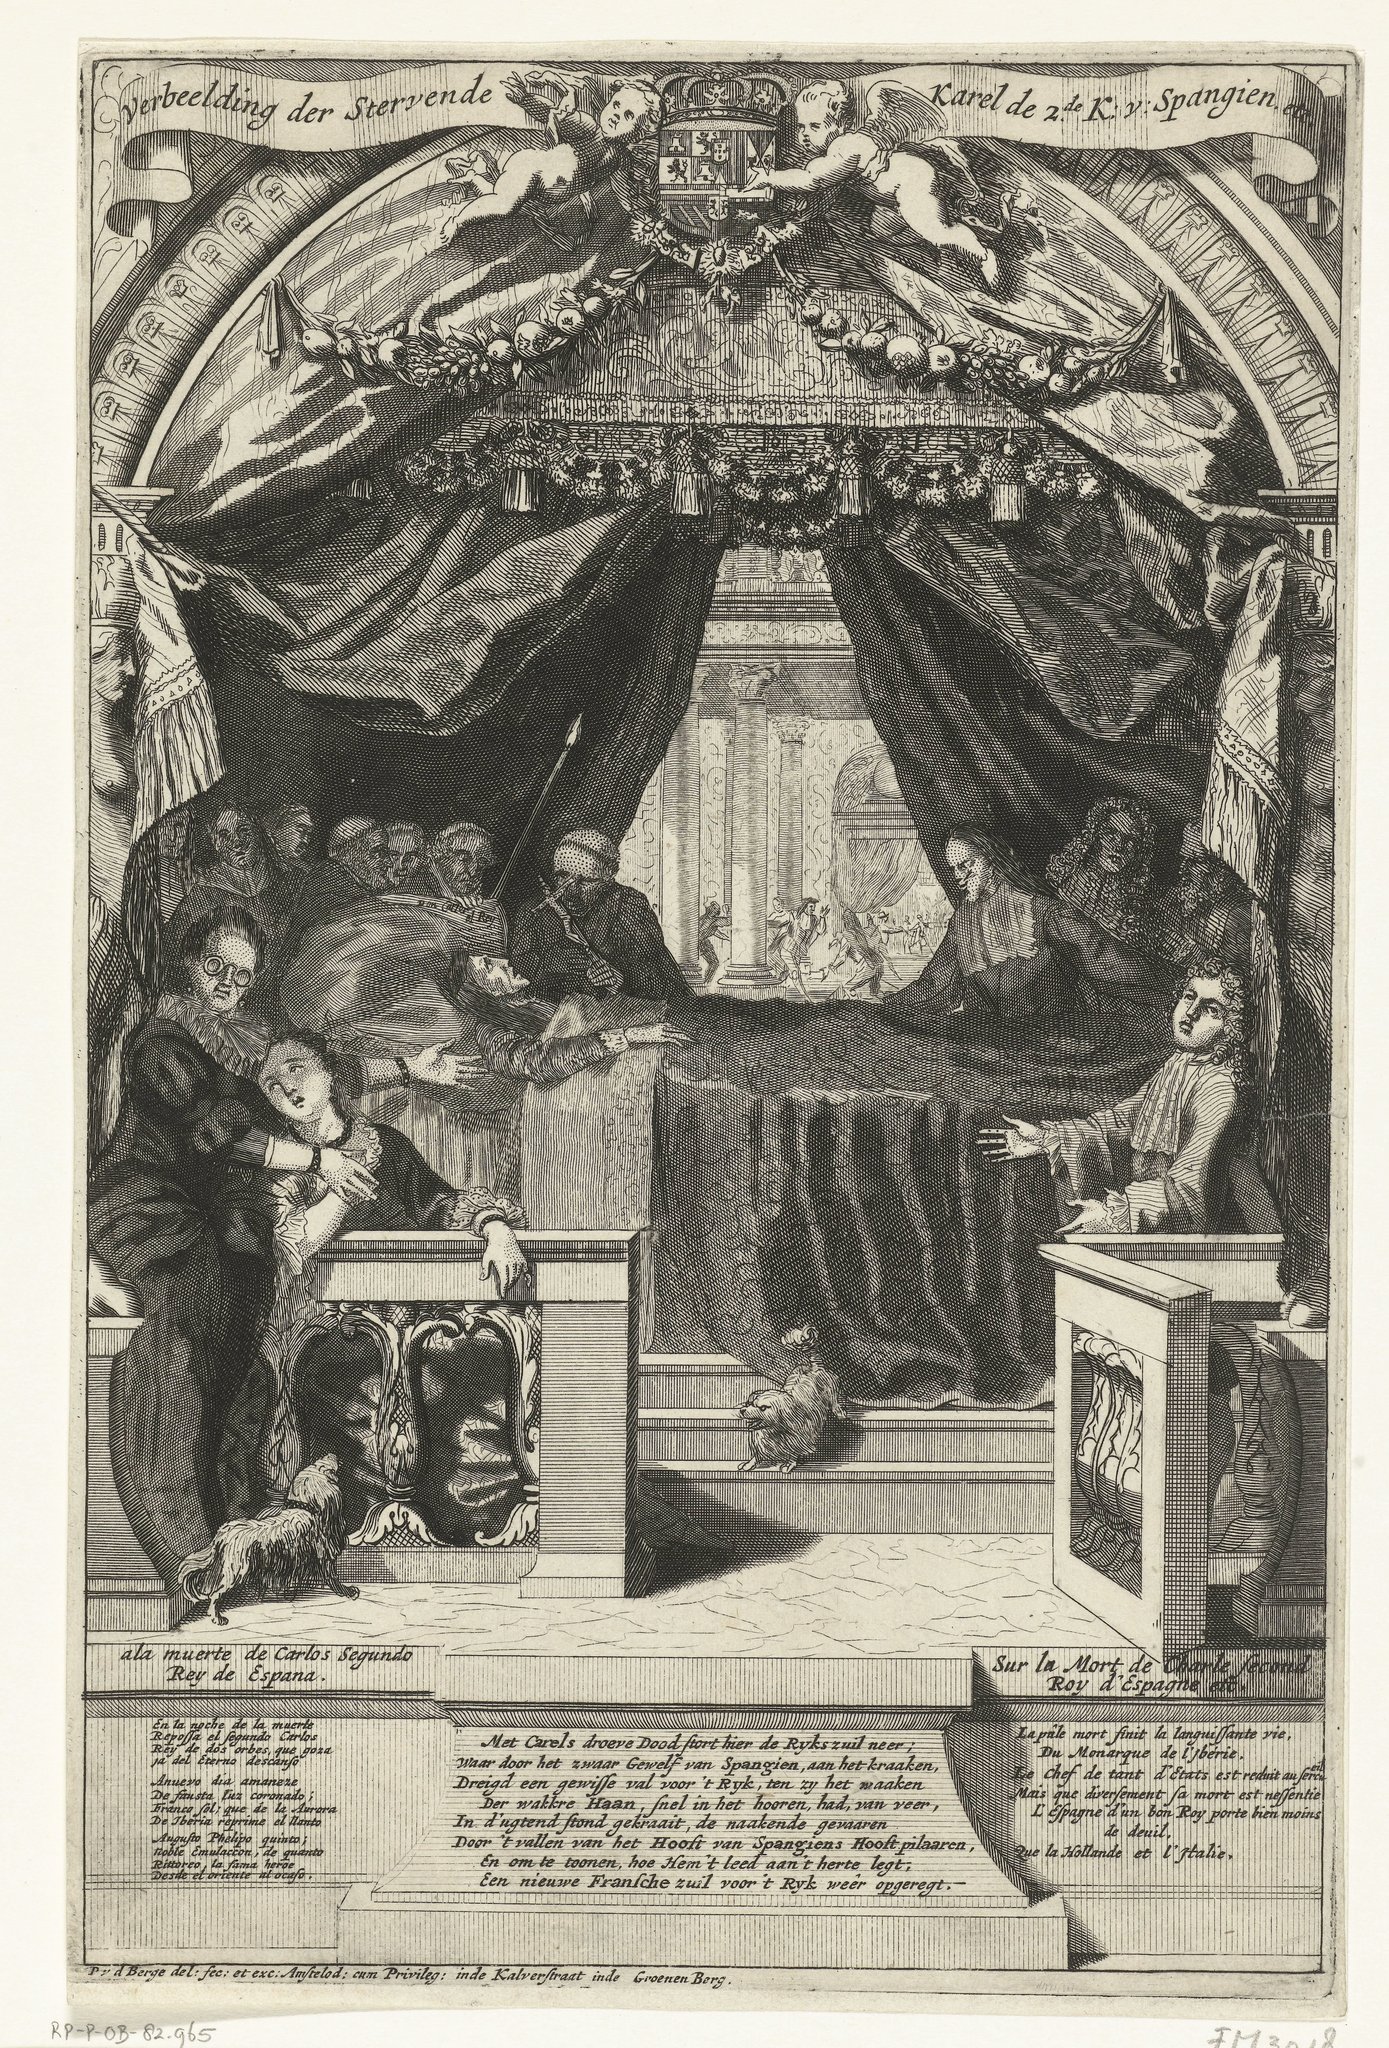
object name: print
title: Verbeelding der Stervende Karel de 2de K: v: Spangien. etc.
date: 1701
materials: paper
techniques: engraving, etching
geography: amsterdam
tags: karel ii (koning van spanje), deathbed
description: Het sterven van de Spaanse koning Karel II op 1 november 1700. De koning op zijn sterfbed met baldakijn omringd door geestelijken, hovelingen en familie. Bovenaan twee engelen met het Spaanse wapen. Onderaan verzen in het Spaans, Nederlands en Frans op de dood van de koning.